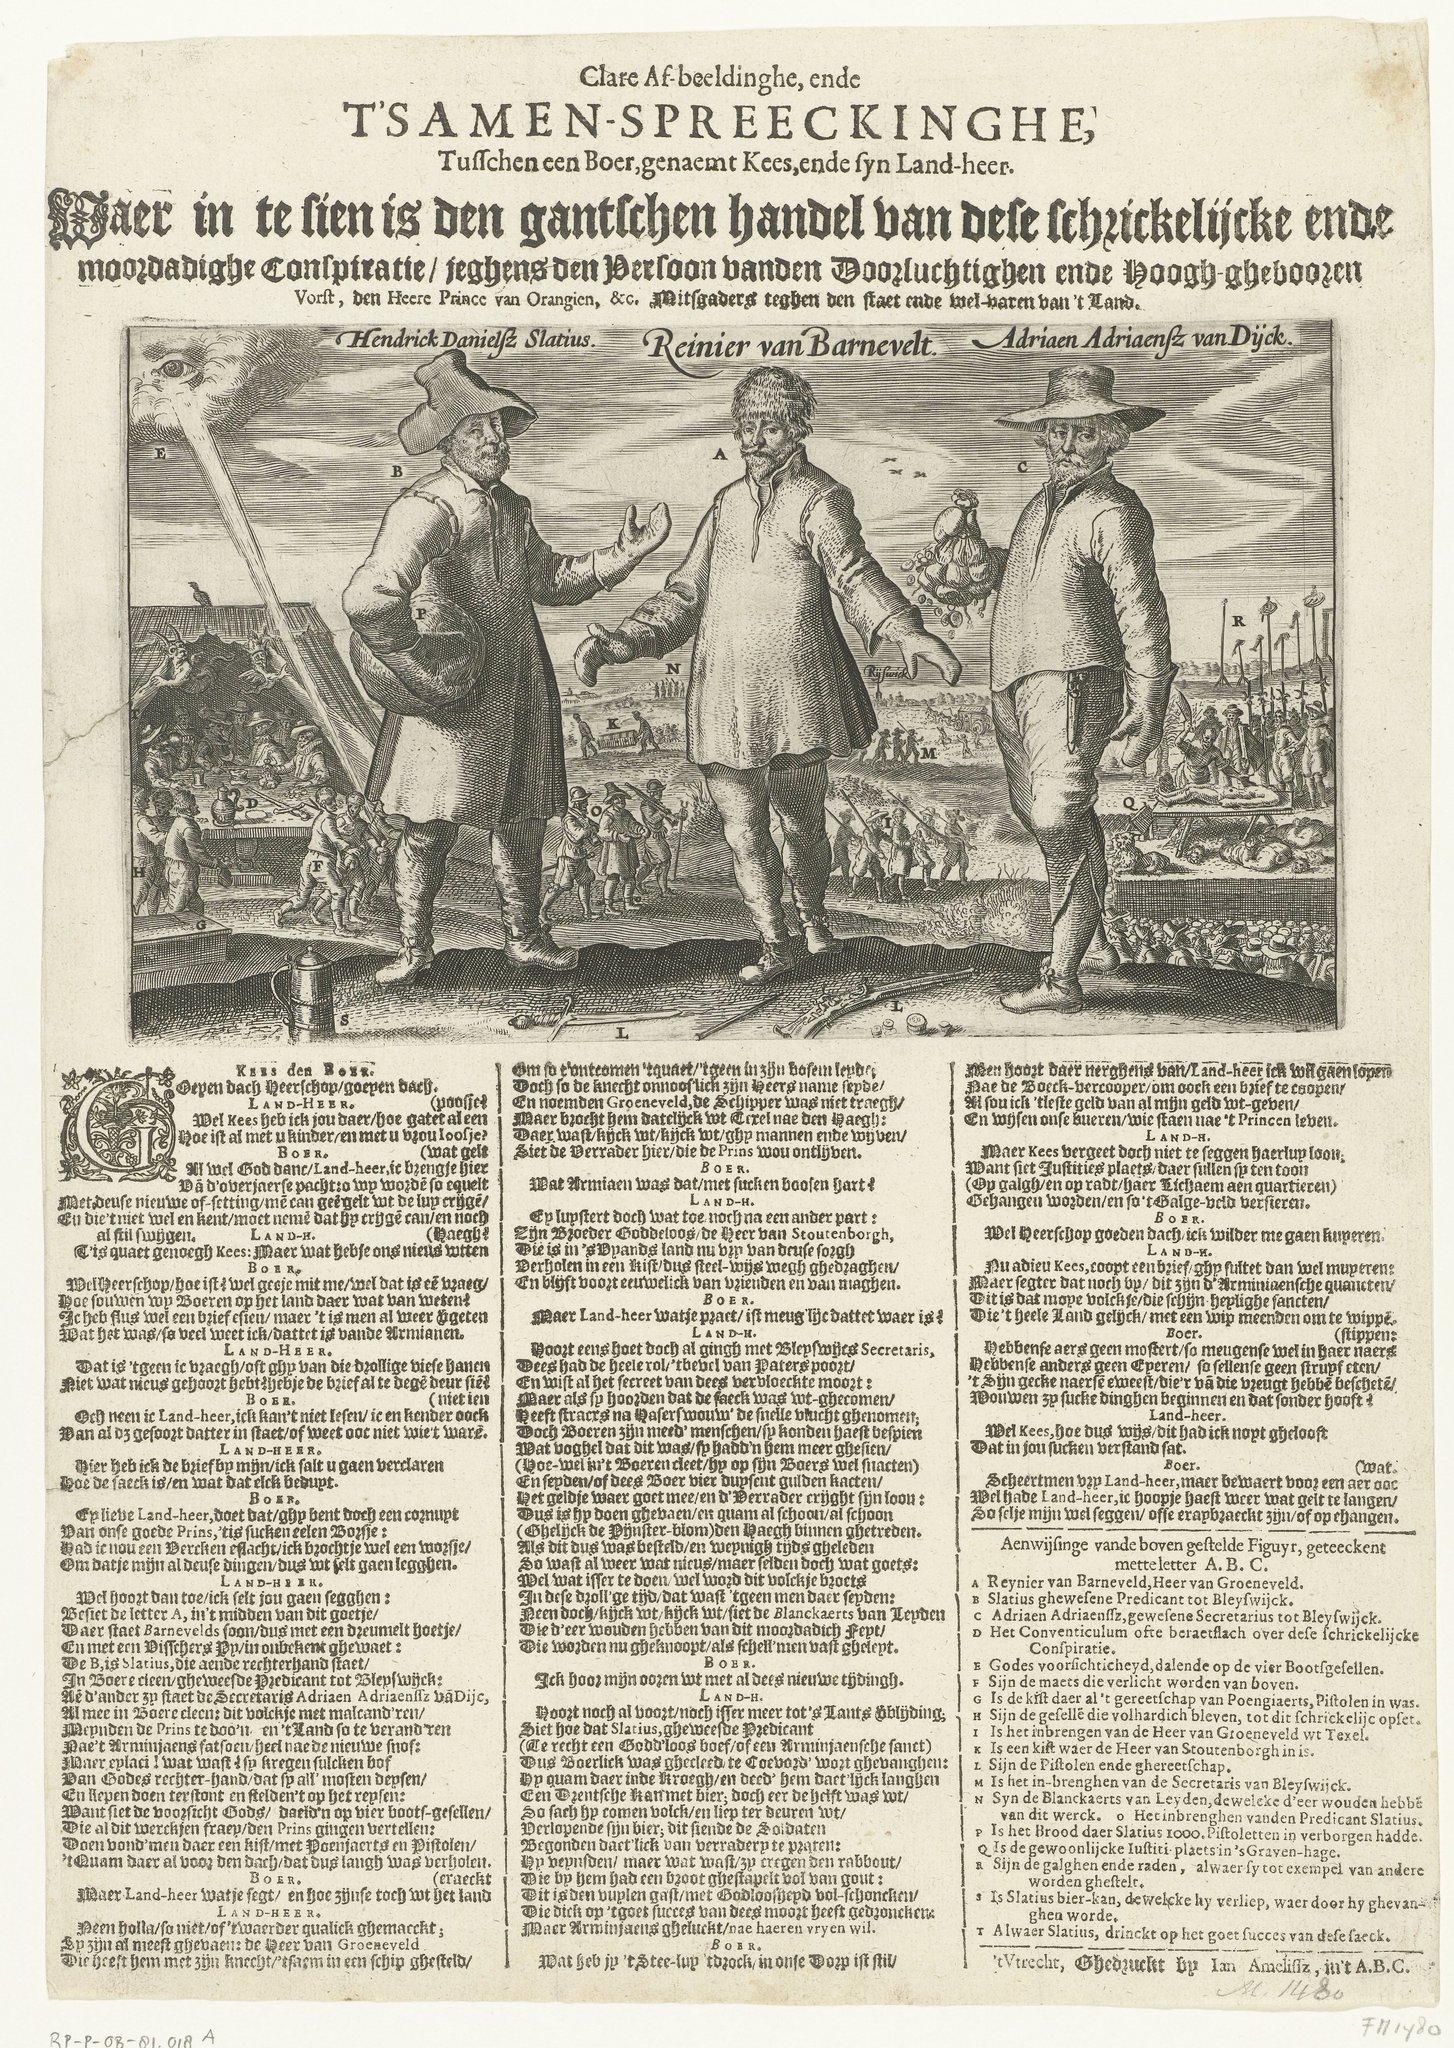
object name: print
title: Clare Af-beeldinghe, ende T'Samen-Spreeckinghe, Tusschen een Boer, genaemt Kees, ende syn Land-heer. Waer in te sien is den gantschen handel van dese schrickelijcke ende moordadighe Conspiratie / jeghens den Persoon vanden (...) Prince van Orangien, &c. Mitsgaders teghen den staet ende wel-varen van 't Land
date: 1623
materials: paper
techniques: engraving, etching, letterpress printing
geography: utrecht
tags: the hague, maurice (prince of orange), (revolutionary) plot, conspiracy, mutilation of the corpse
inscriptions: collector's mark: Lugt 240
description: De drie hoofdrolspelers in de samenzwering tegen Maurits, Hendrick Danielsz Slatius, Reinier van Barnevelt en Adriaen Adriaensz van Dijck. Op de achtergrond in het klein de samenzwering in een tent met duivels, arrestatie, vlucht en executies. Onder de voorstelling de samenspraak tussen een boer en zijn landheer en de legenda in 3 kolommen in het Nederlands.